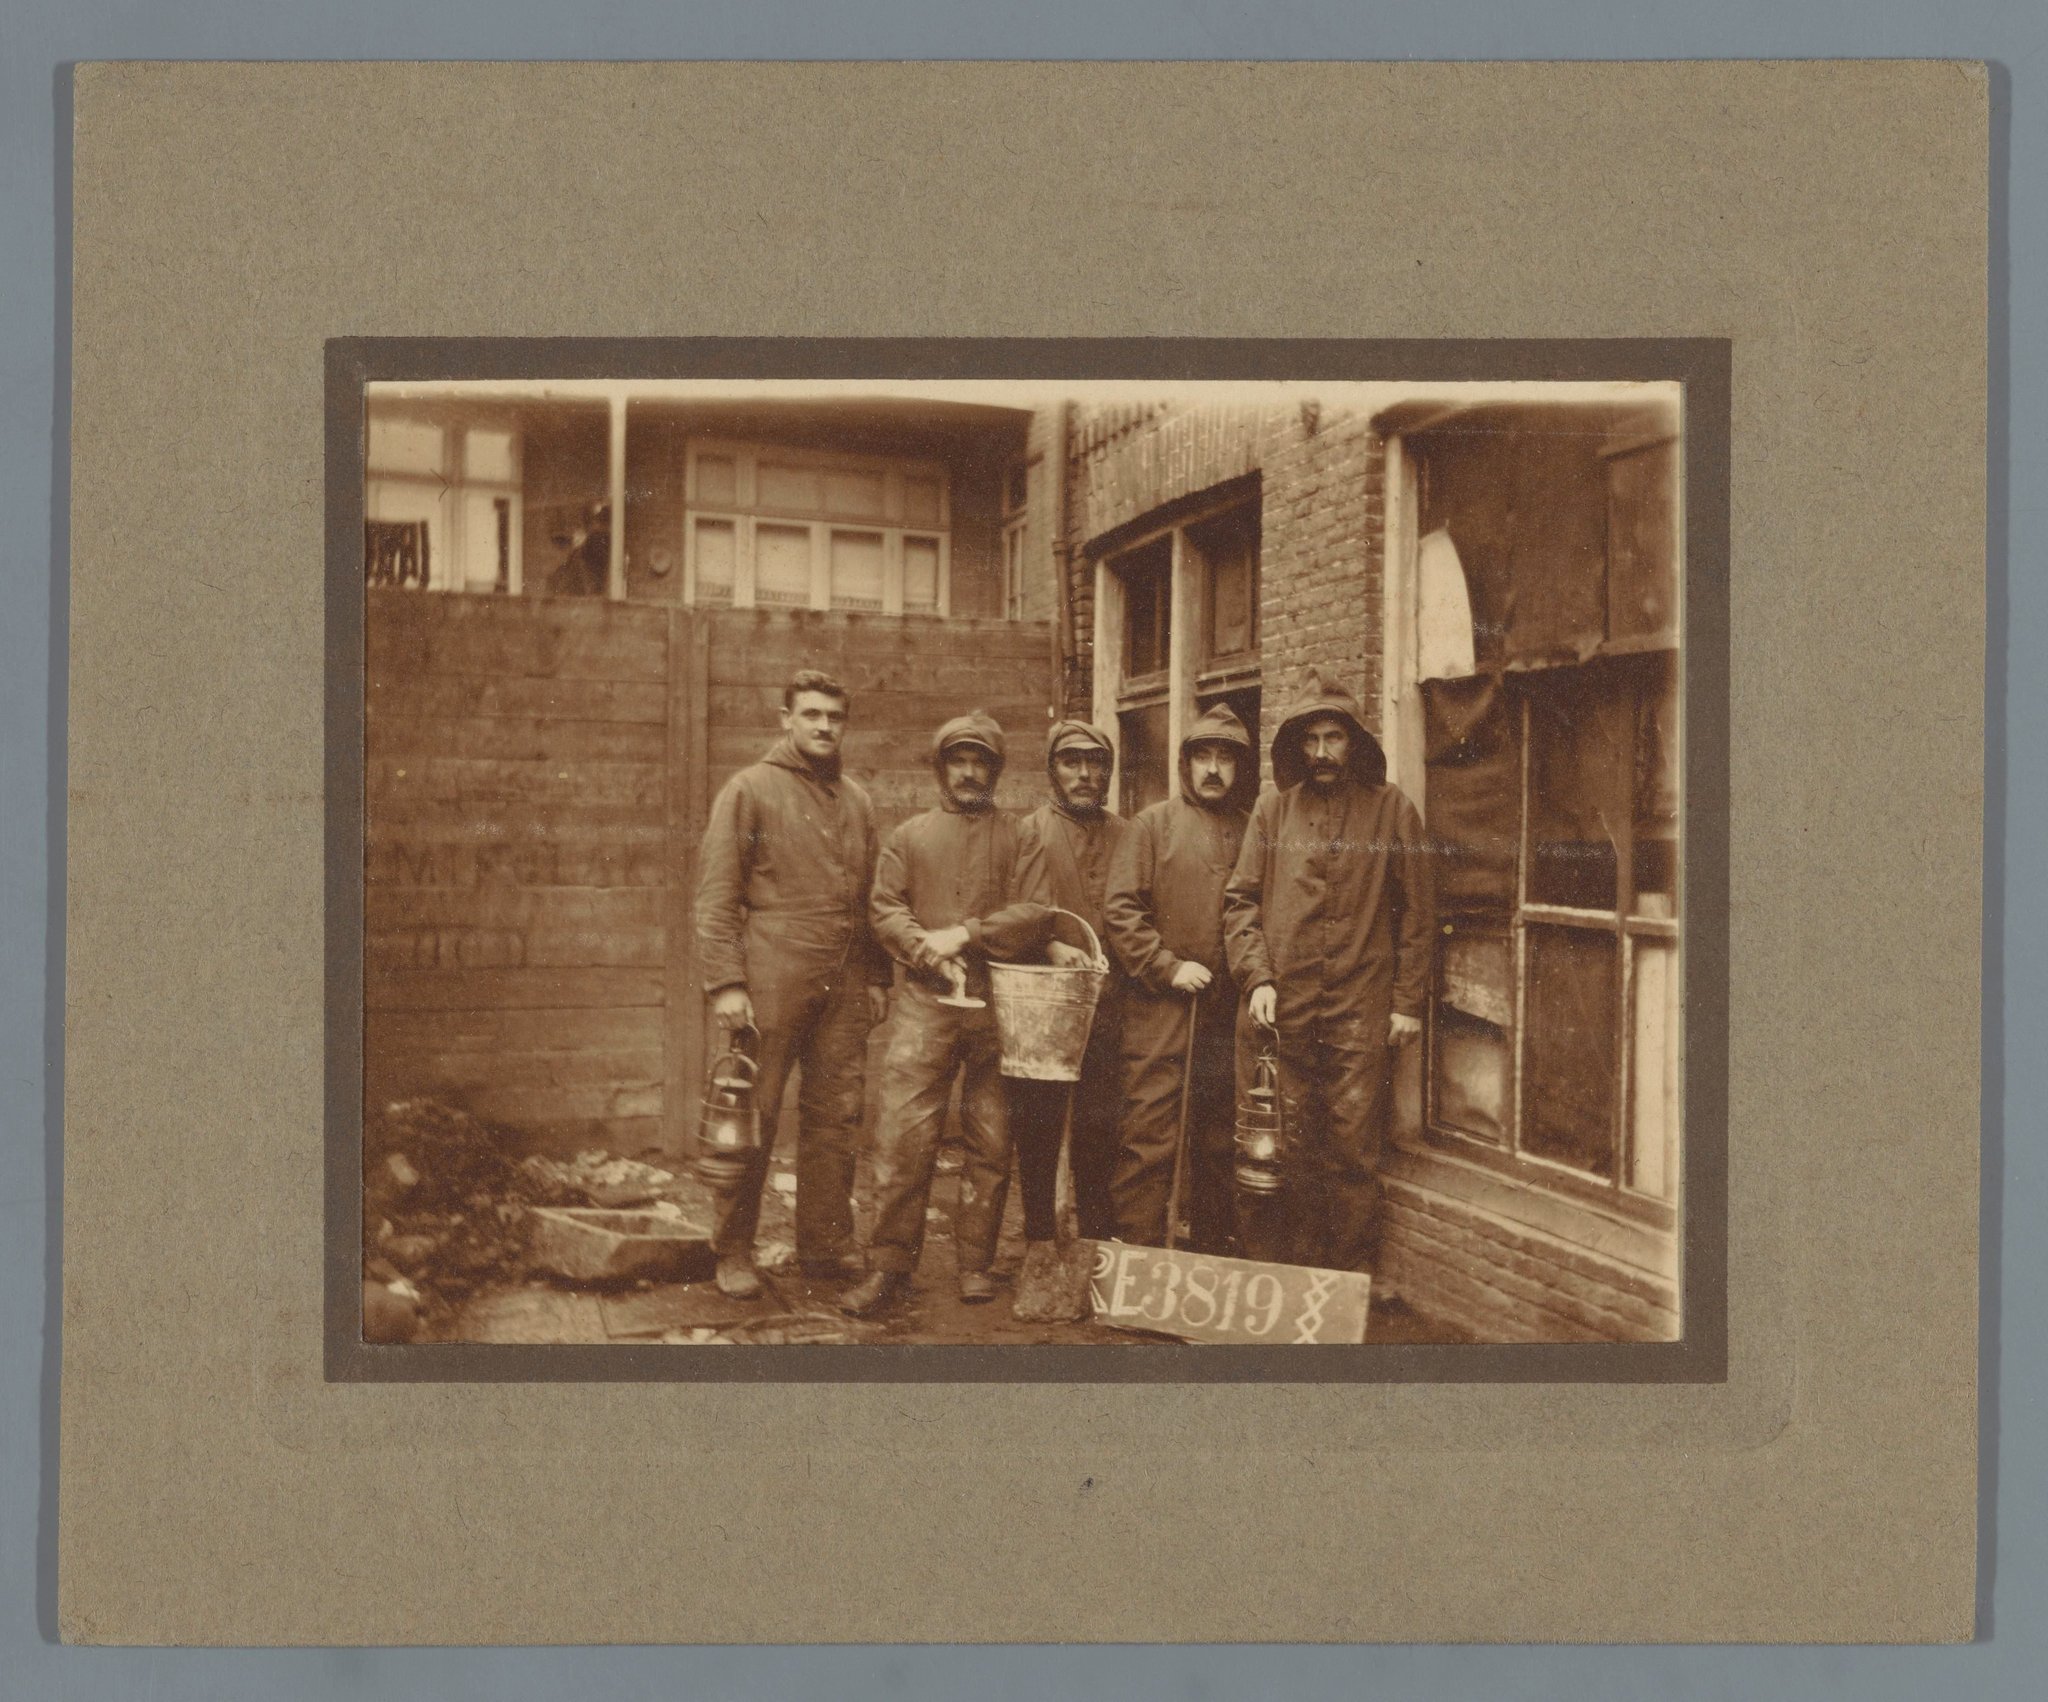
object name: photograph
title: Groepsportret van vijf onbekende mannen in werkkleding met gaslampen en een emmer in een achtertuin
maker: Anonymous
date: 1900-1920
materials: cardboard, photographic support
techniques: gelatin silver print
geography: netherlands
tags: gas-lamp, backyard, anonymous historical persons portrayed in a group, in a group-portrait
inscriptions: name: ‘L.J. Smals’